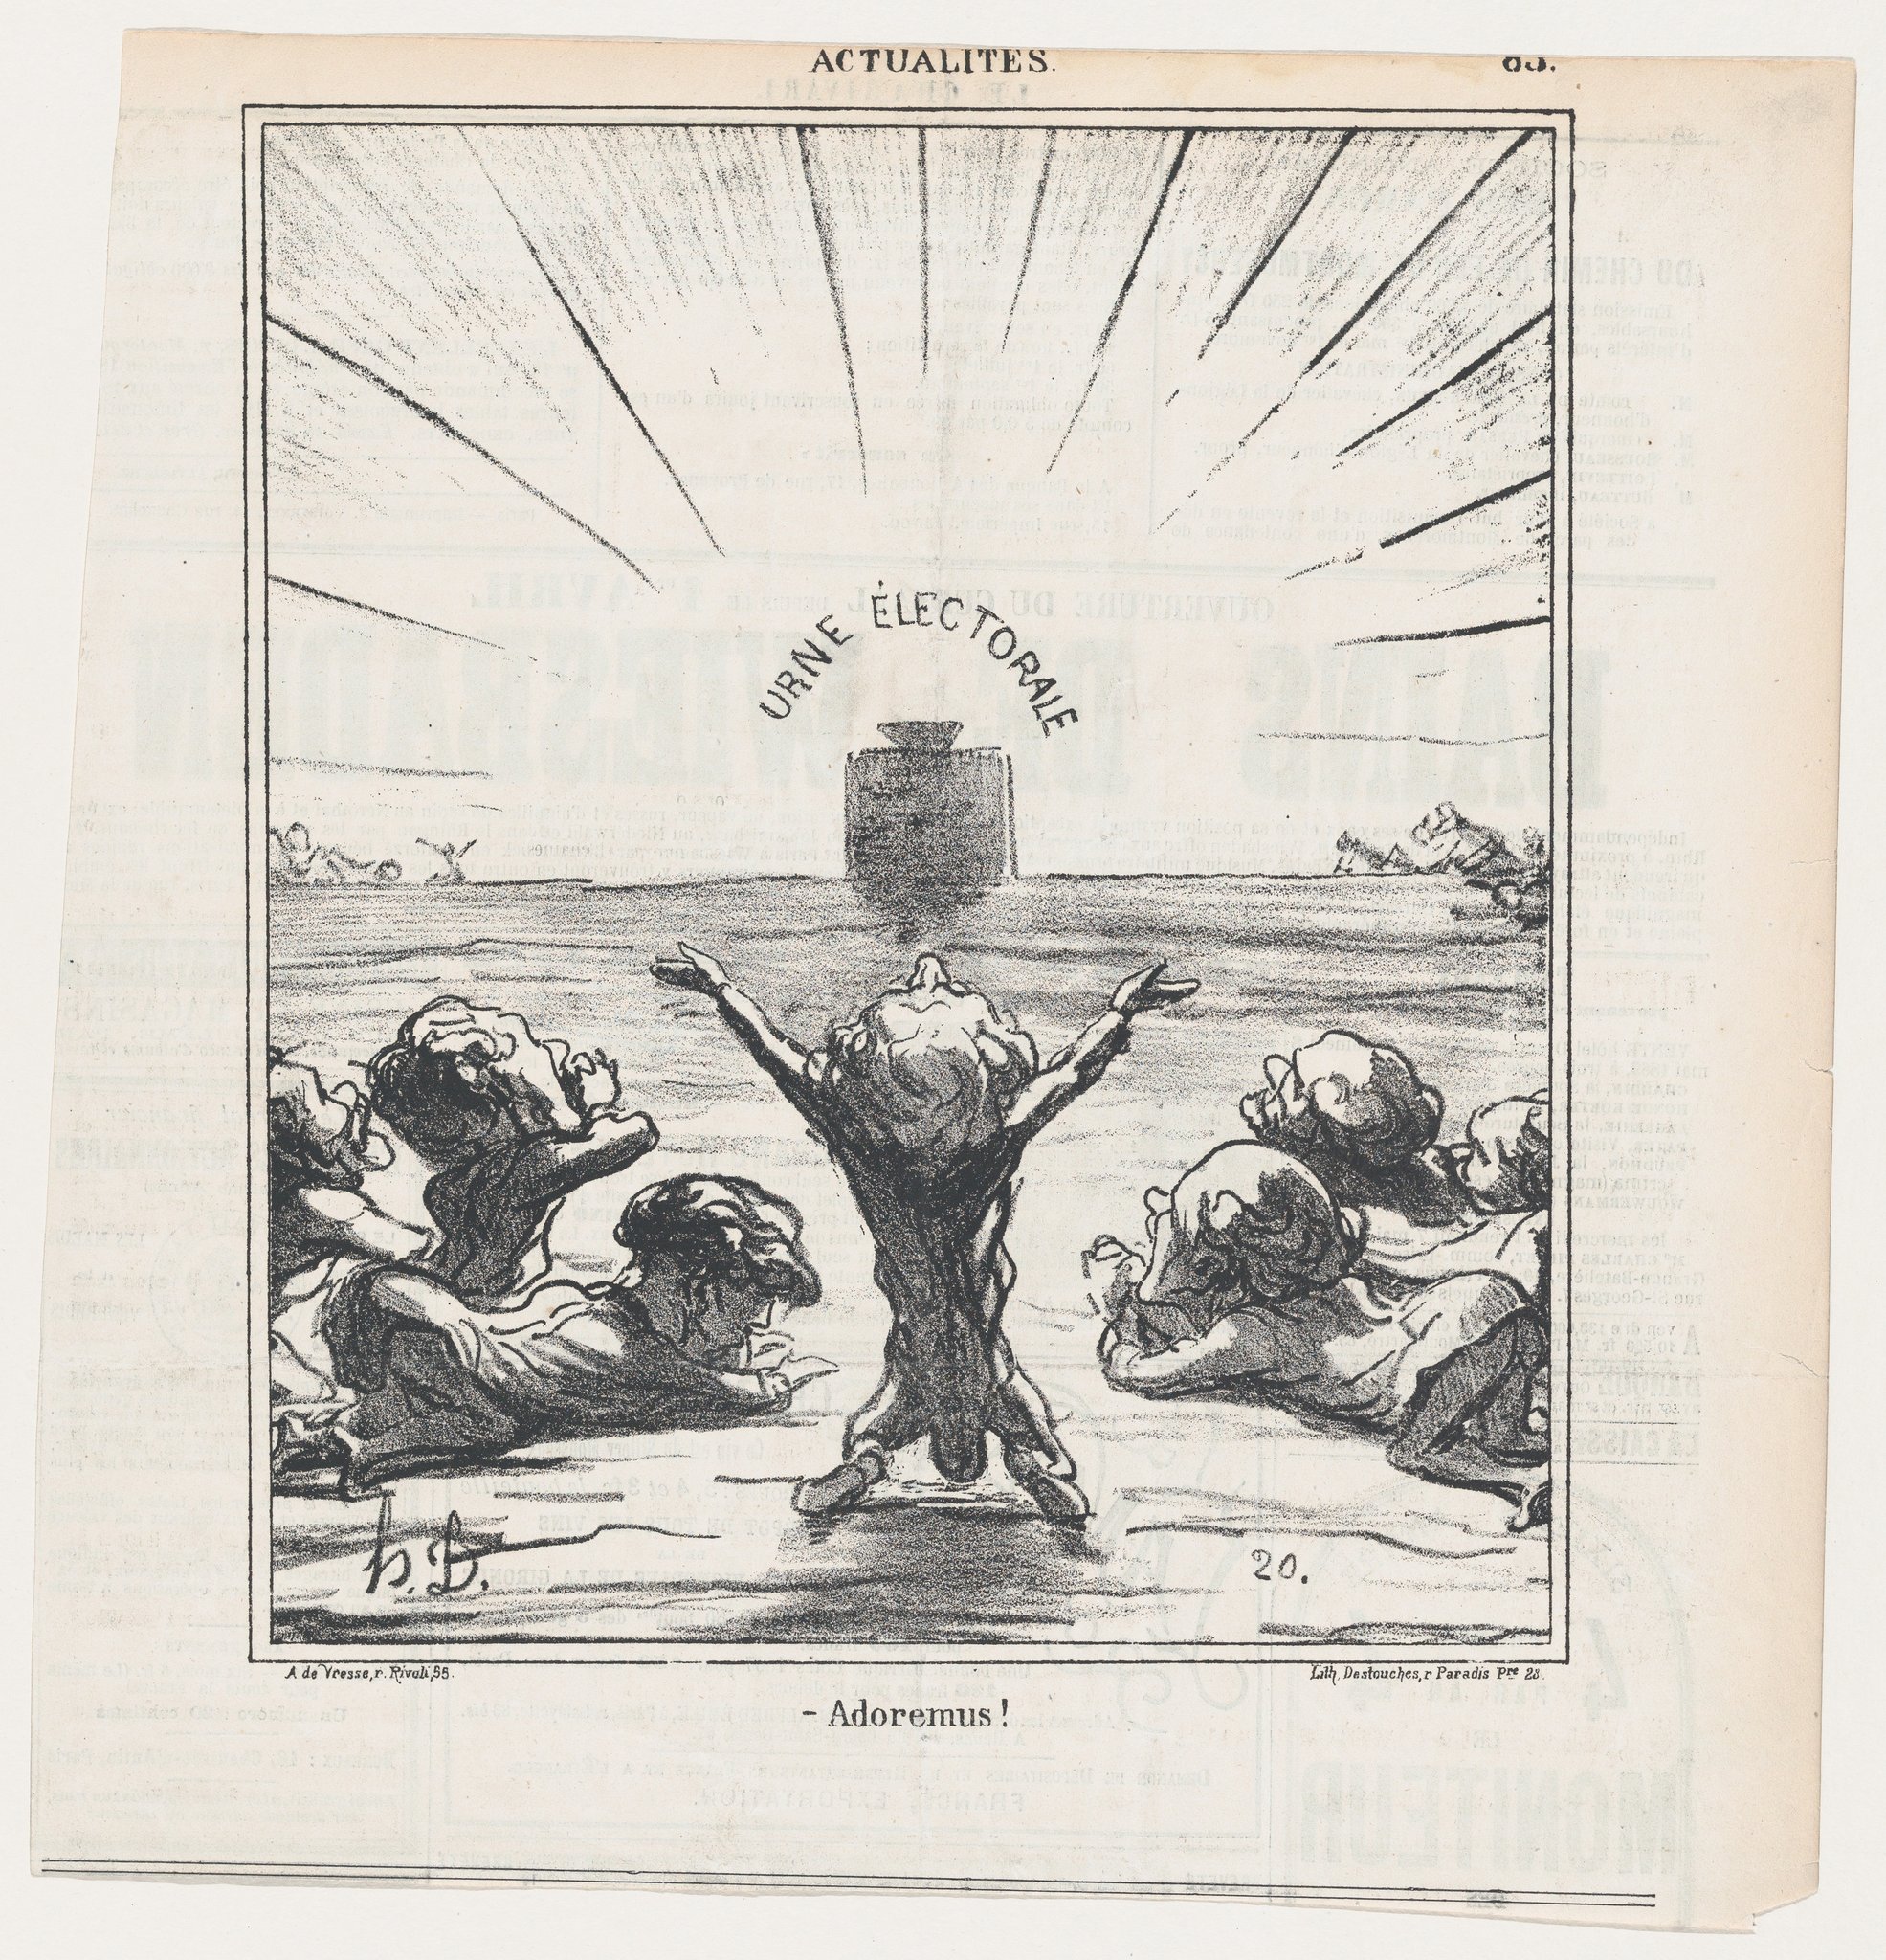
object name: print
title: We worship you, beloved voter, from 'News of the day,' published in "Le Charivari"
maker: honoré daumier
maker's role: artist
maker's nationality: french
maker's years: 1808-1879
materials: paper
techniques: lithograph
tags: satire,elections,men,praying